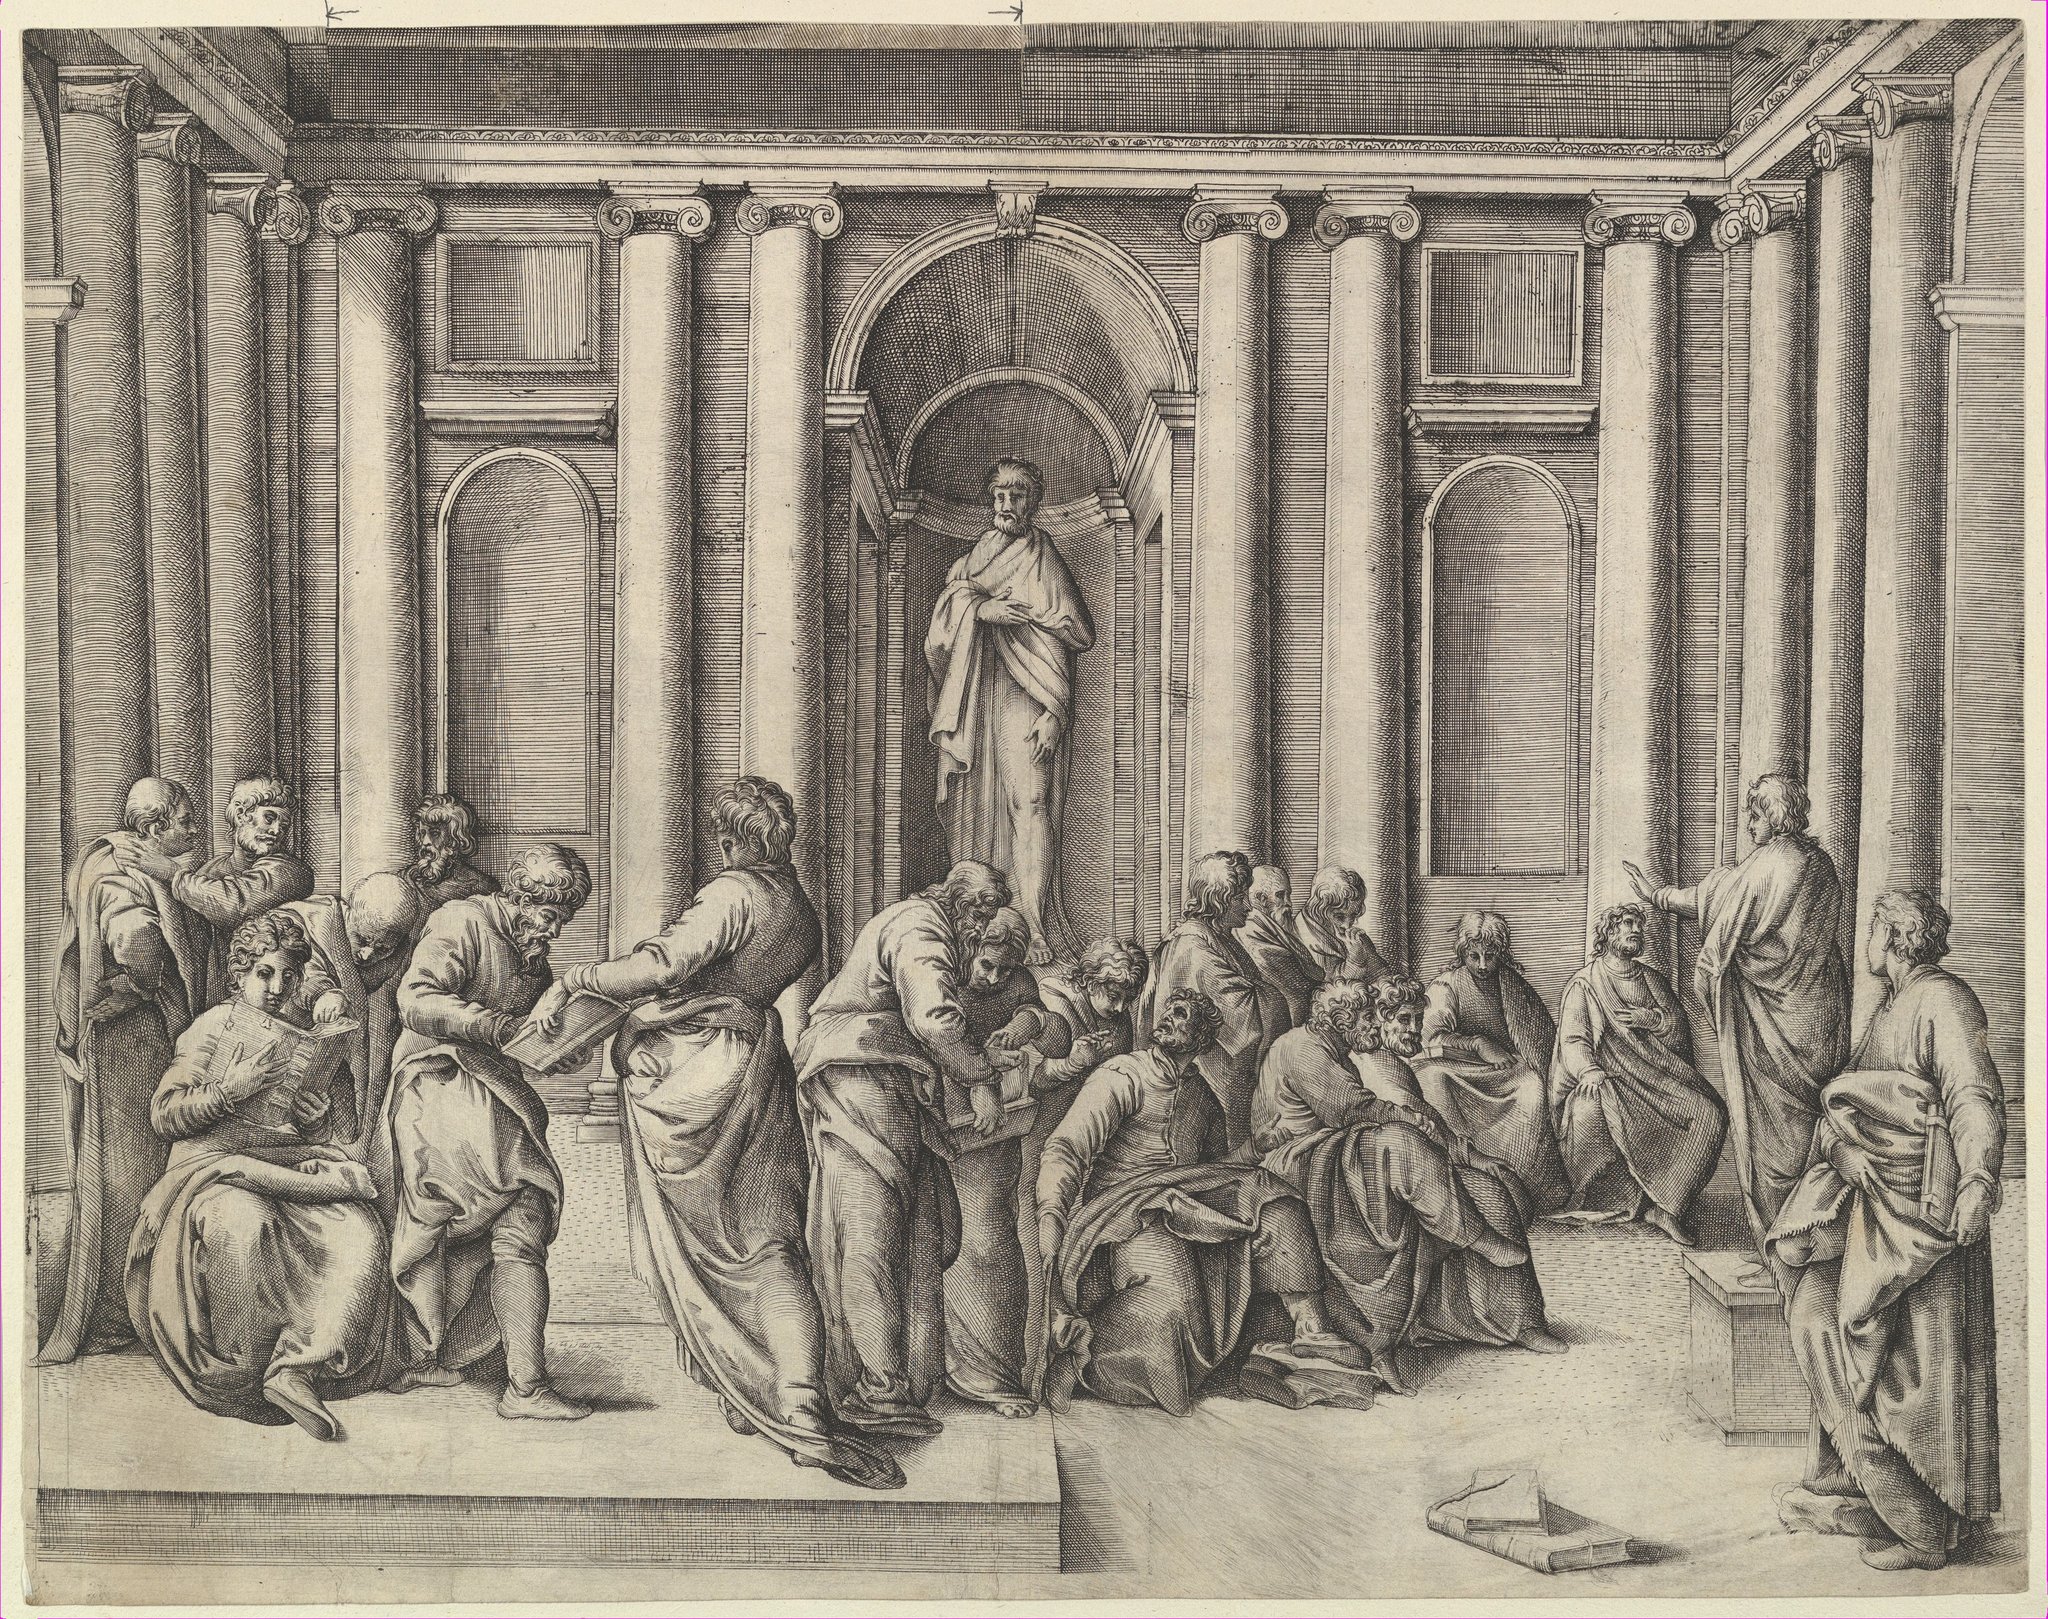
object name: print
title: Christ among the Doctors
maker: battista franco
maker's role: artist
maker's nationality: italian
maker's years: 1510-1561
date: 1530-1561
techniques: engraving, etching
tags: men,christ,doctors